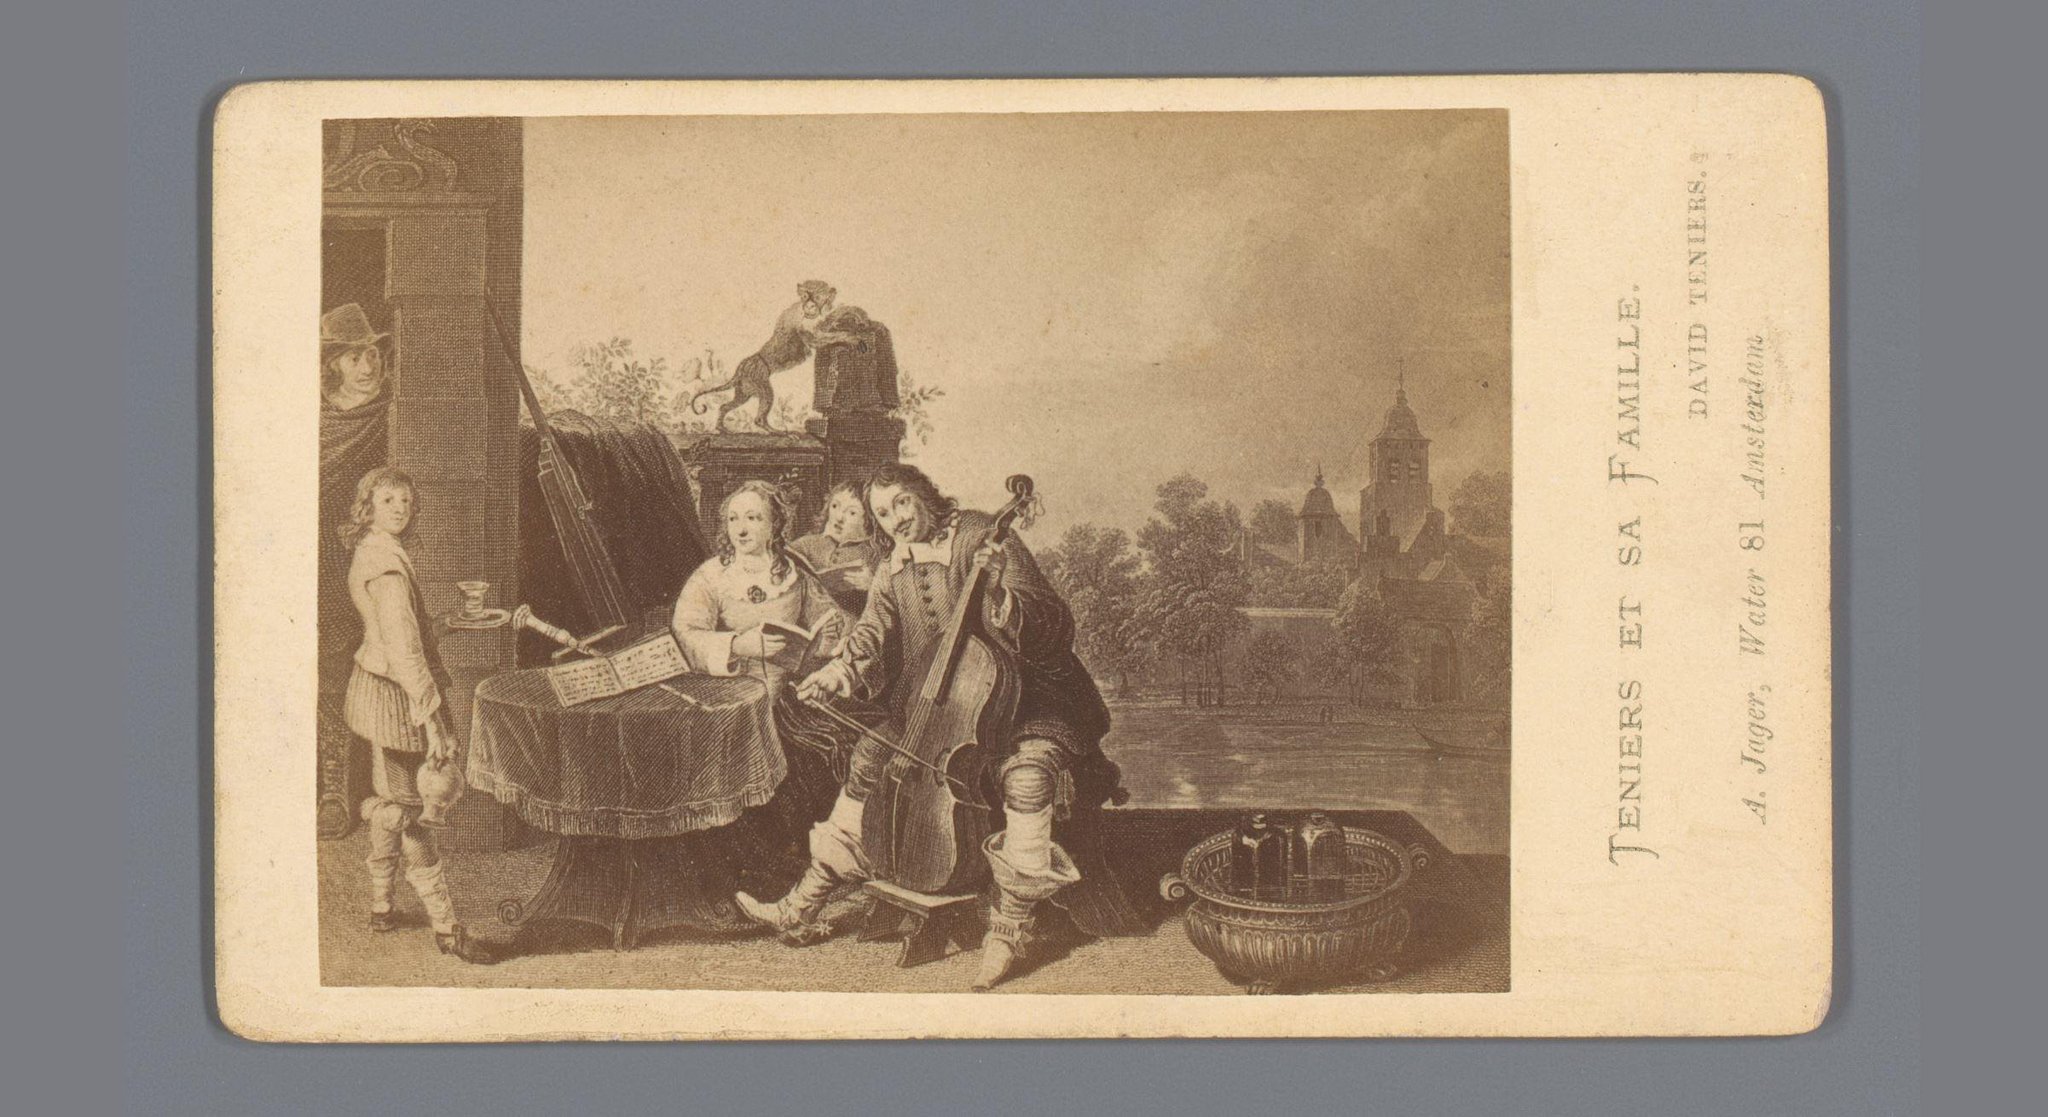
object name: carte de visite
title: Teniers et sa famille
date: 1855-1885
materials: cardboard, paper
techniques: albumen print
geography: amsterdam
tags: the artist and his family, relatives, etc., making music; musician with instrument, painter making music, painter with musical instrument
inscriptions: inscription: ‘David Teniers./ A. Jager, Water 81 Amsterdam.’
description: De prent is van de hand van Jacques-Philippe le Bas, gemaakt naar een schilderij van David Teniers de jongere, en bevindt zich nu in het British Museum.